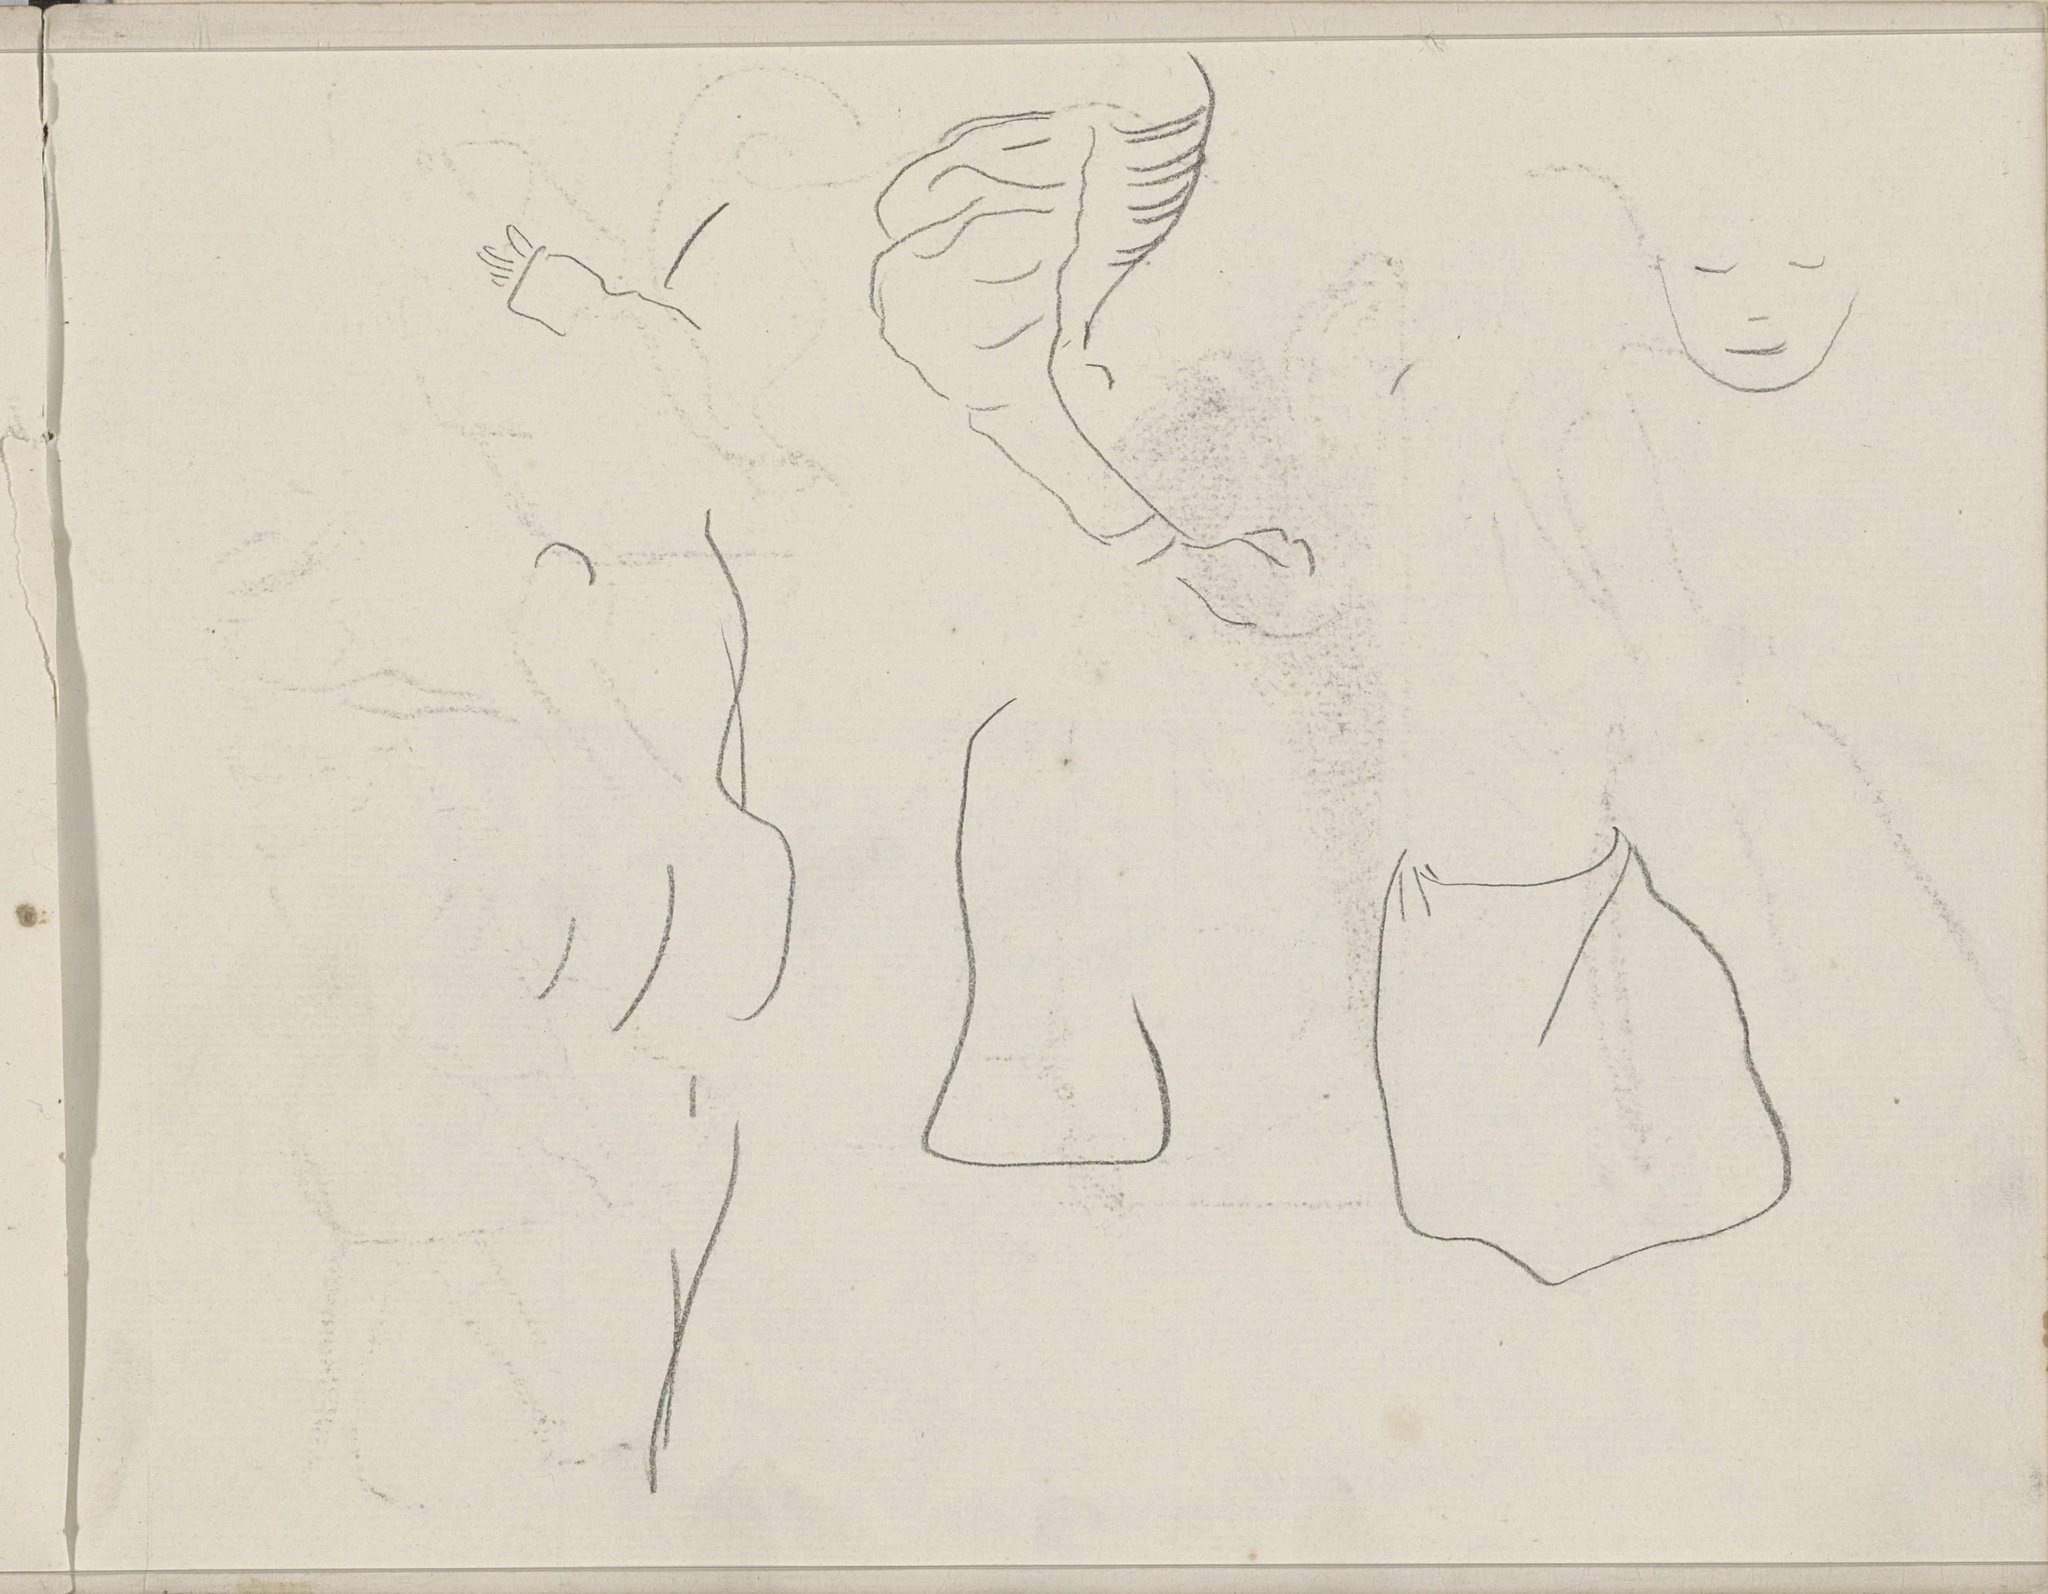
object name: sketchbook leaf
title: Studieblad, onder andere met een gezicht, arm en kledingstukken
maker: carel adolph lion cachet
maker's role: draughtsman, print maker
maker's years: 1864-1945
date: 1896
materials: chalk, paper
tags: face, arms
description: Blad 12 recto uit een schetsboek met 44 bladen.